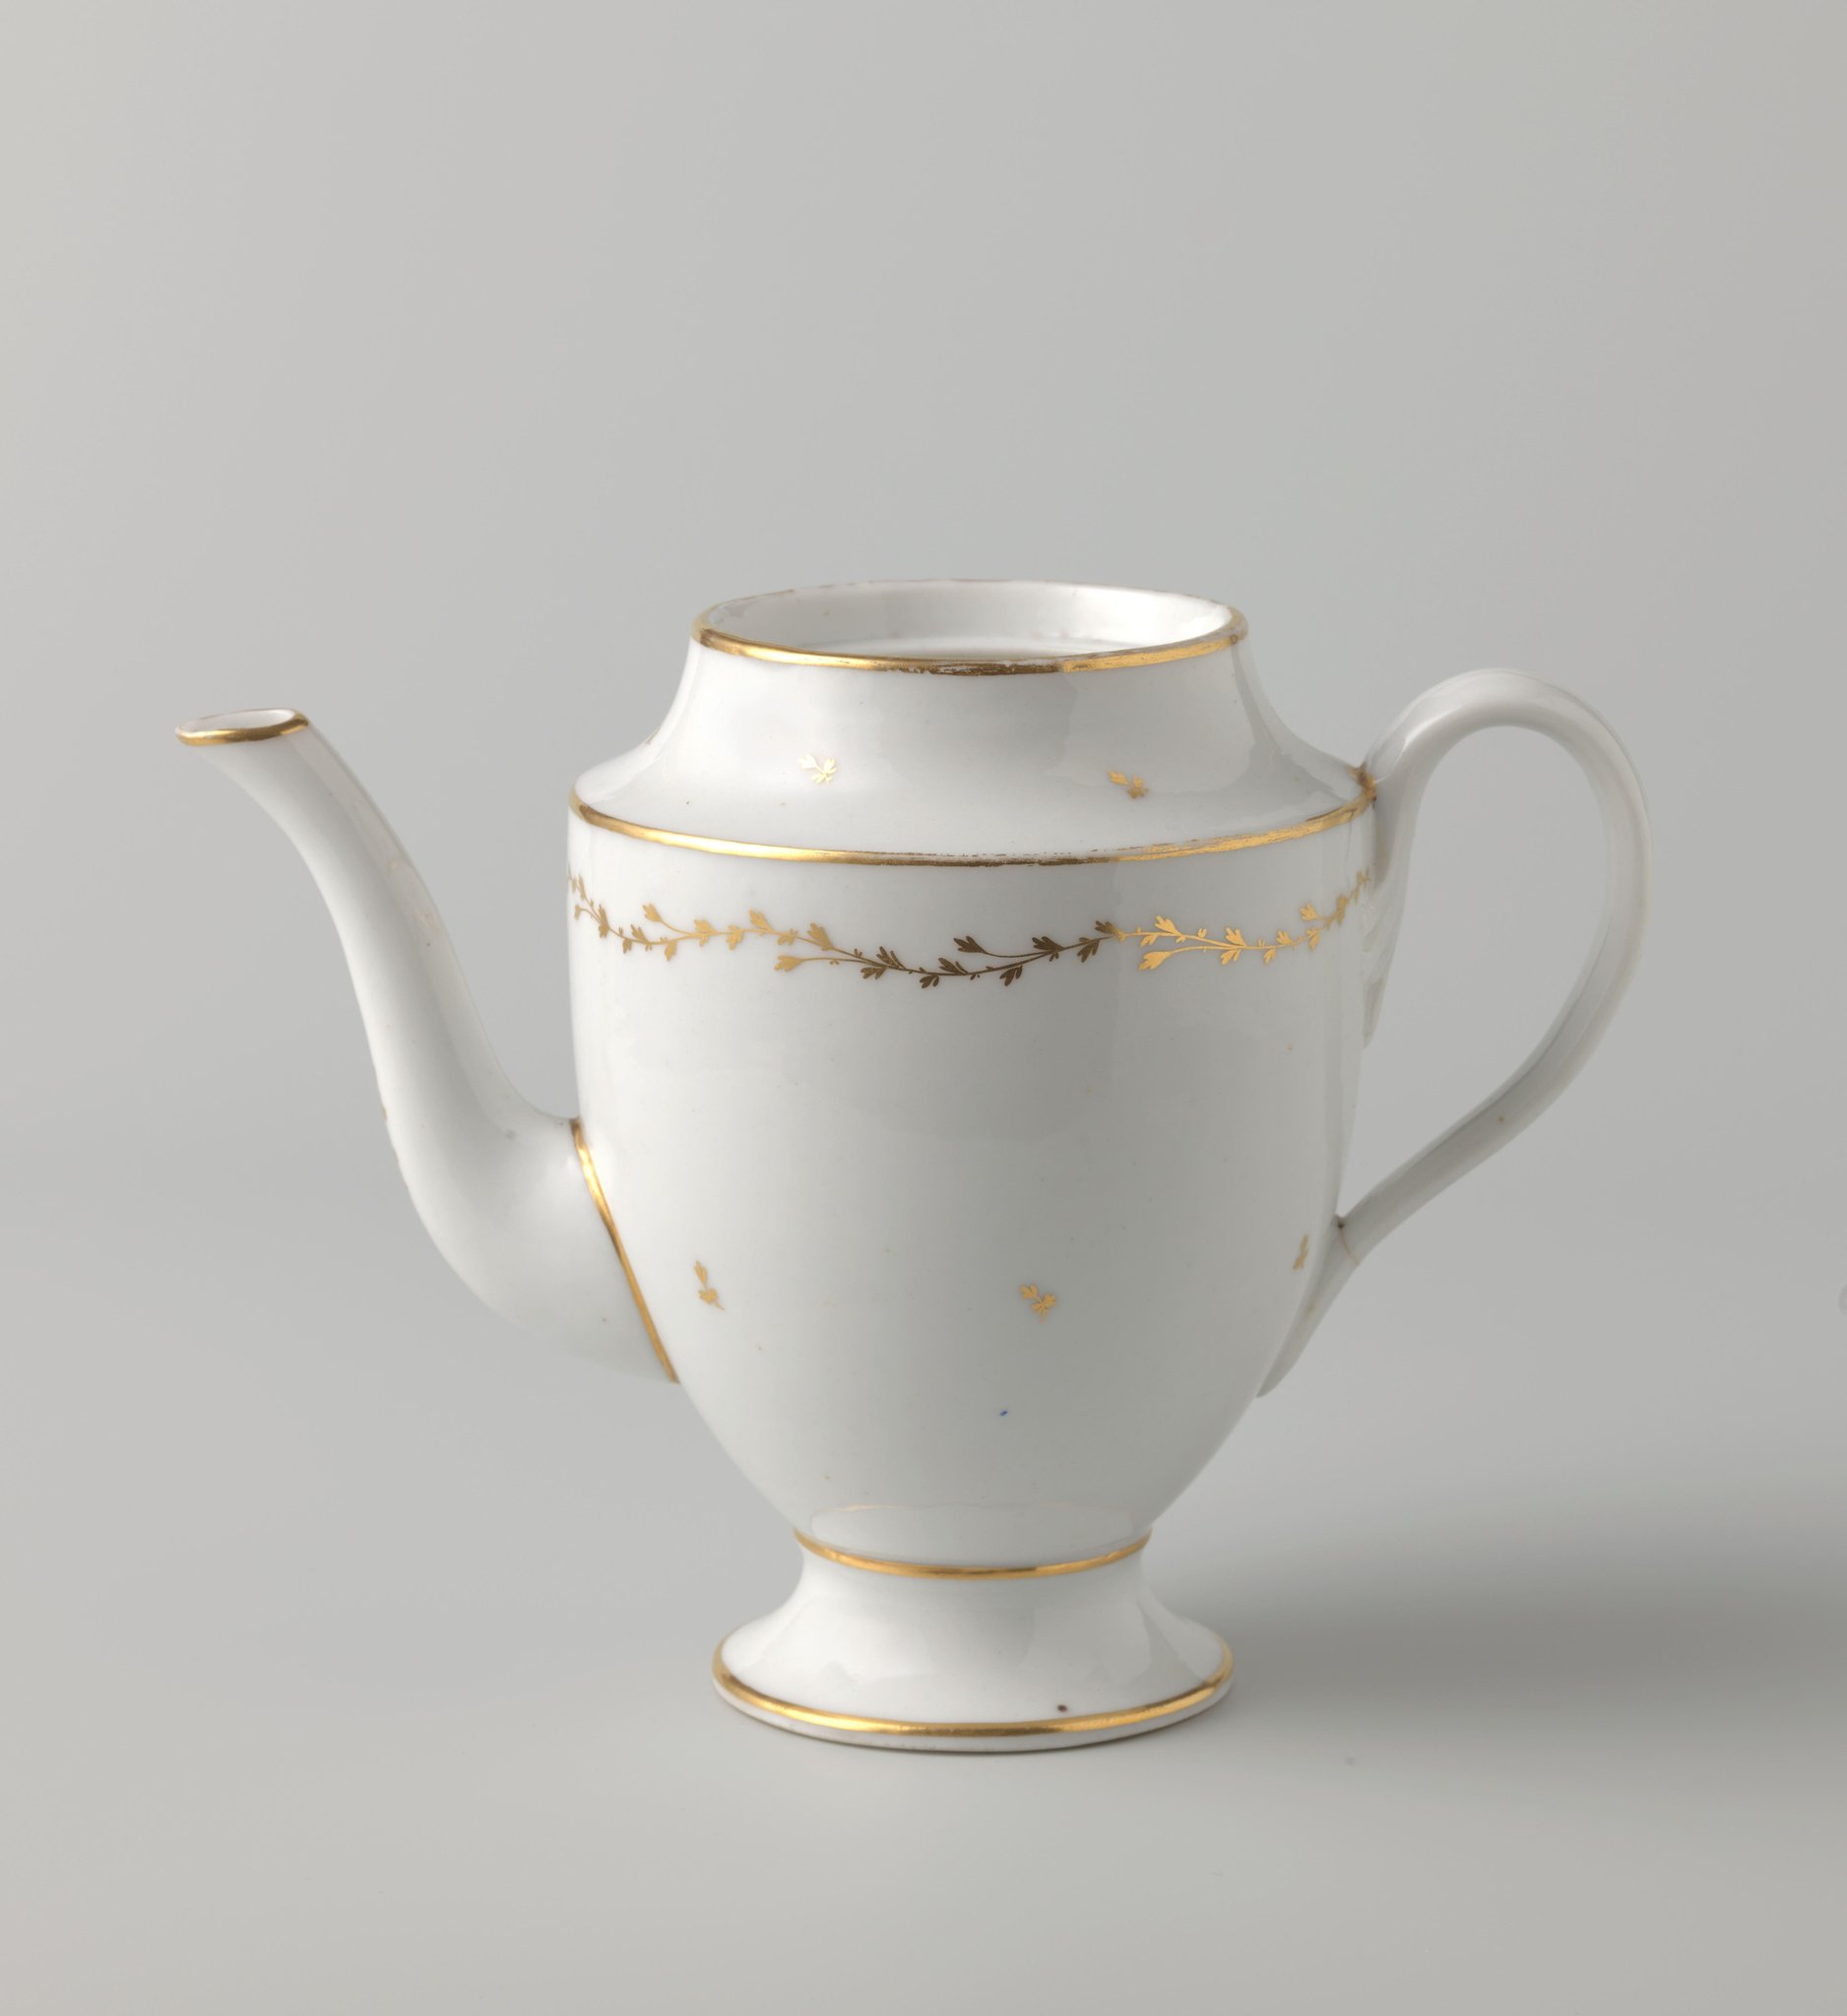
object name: teapot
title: Theepot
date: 1809-1814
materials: porcelain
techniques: painted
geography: nieuwer-amstel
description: Theepot in Empirestijl versierd met slingerblad en gouden biezen langs de randen. De theepot heeft een hoge buik en hol gewelfde voet.